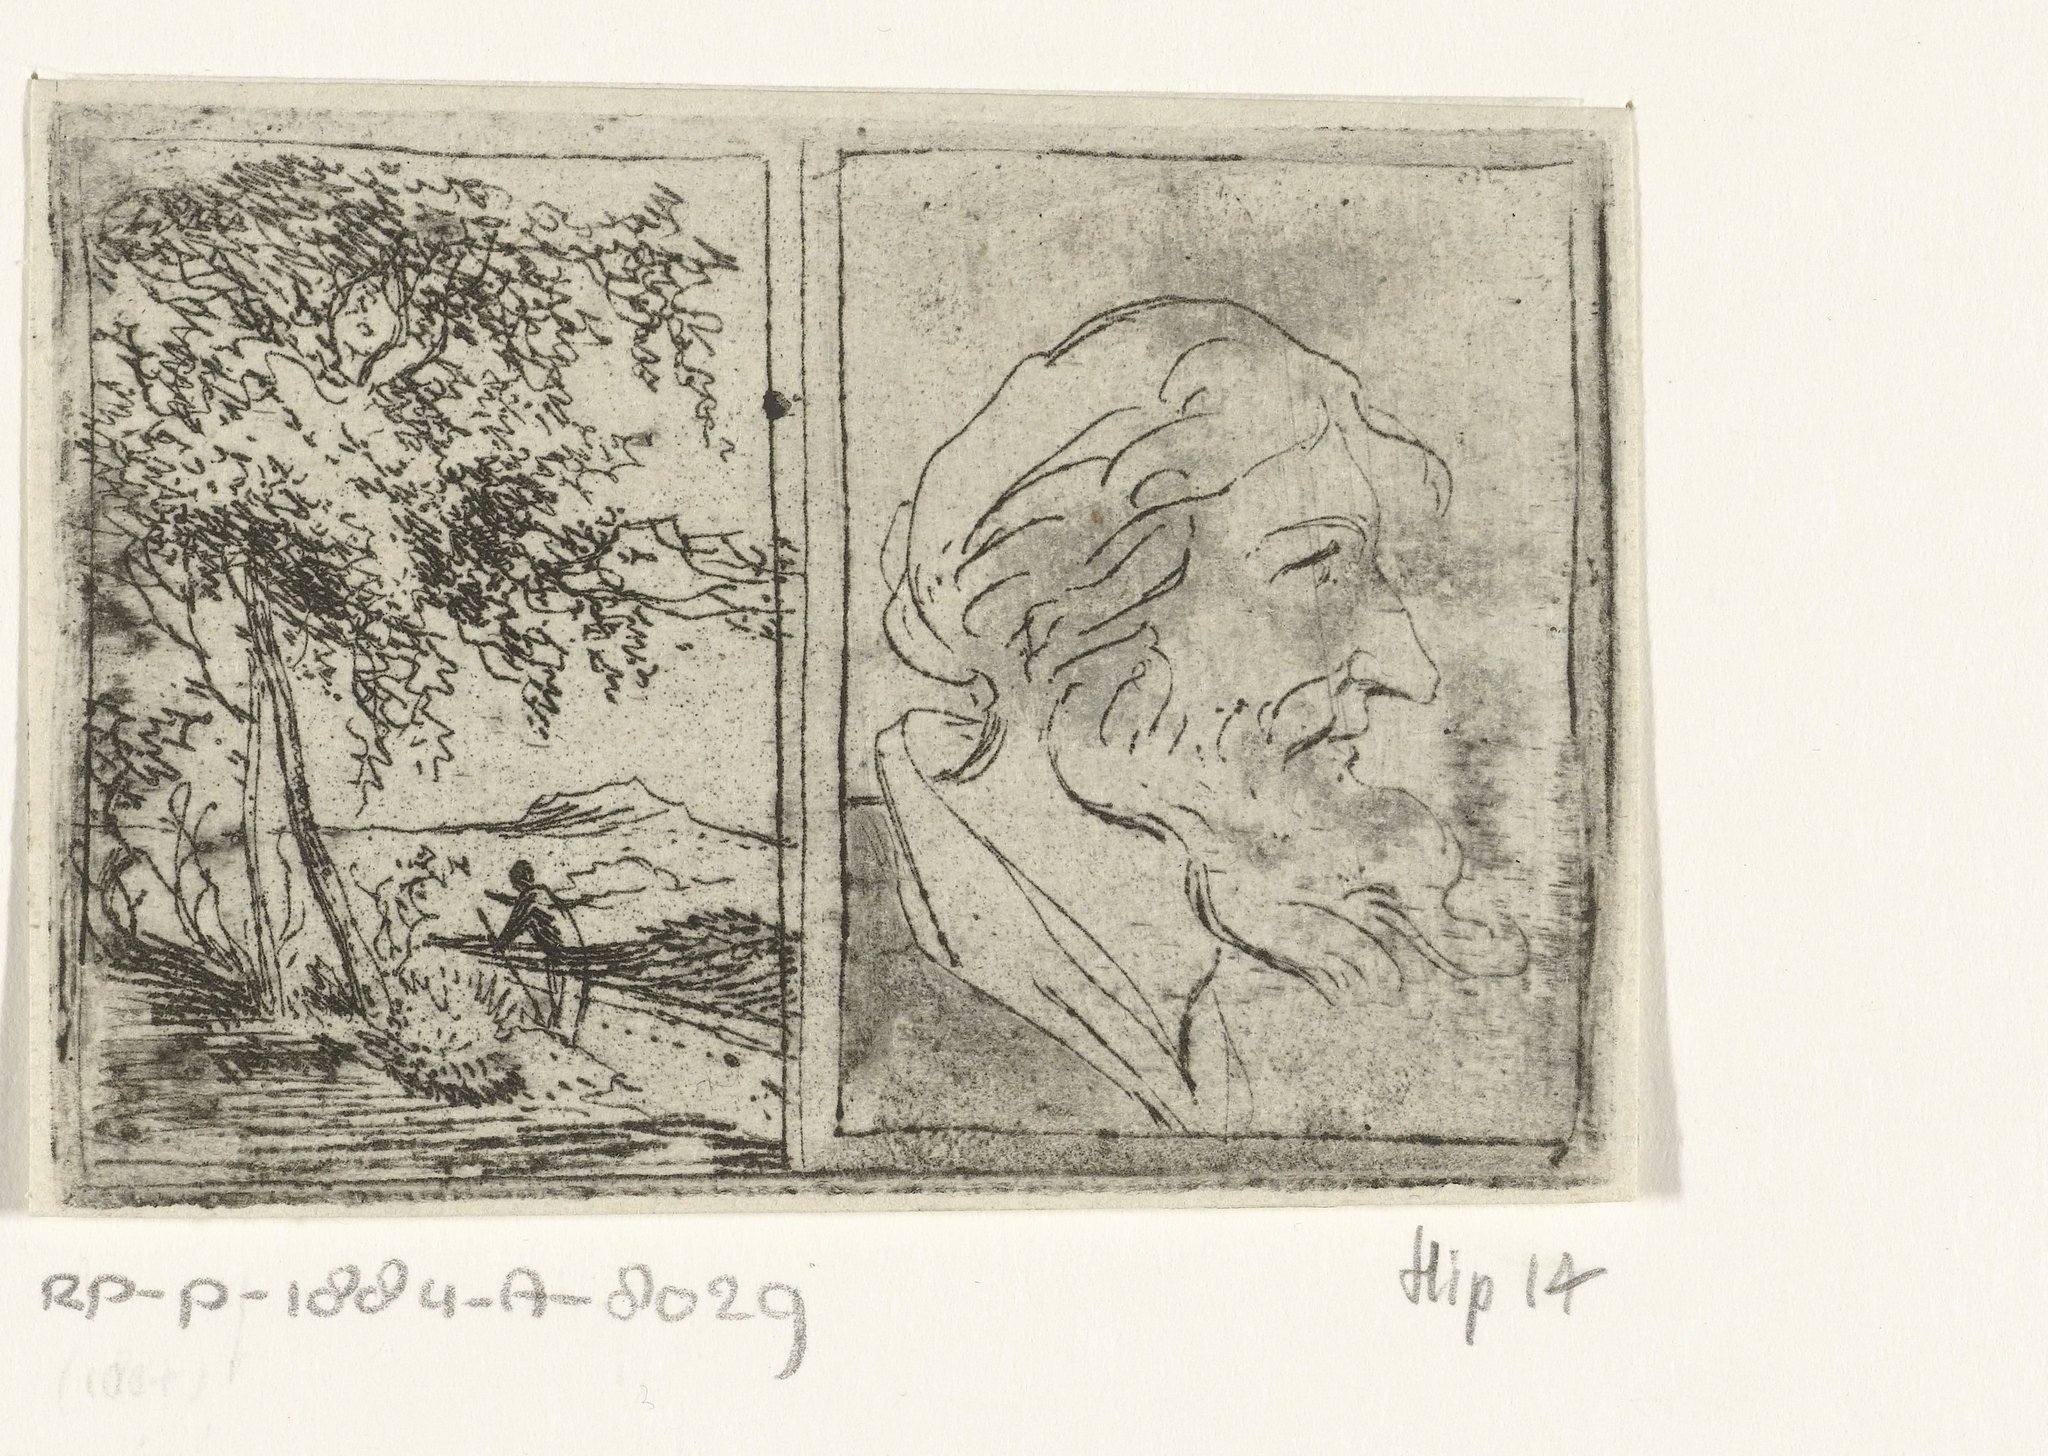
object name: print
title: Landschap en portretstudie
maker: hermanus fock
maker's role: conservator, draughtsman, painter, print maker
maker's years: 1766-1822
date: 1781-1822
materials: paper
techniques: aquatint, etching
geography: amsterdam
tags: face, landscapes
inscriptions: collector's mark: Lugt 2228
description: Twee voorstellingen op één blad. Links een persoon in een landschap met bomen. Rechts een studie van en portret en profil van een man met een baard.